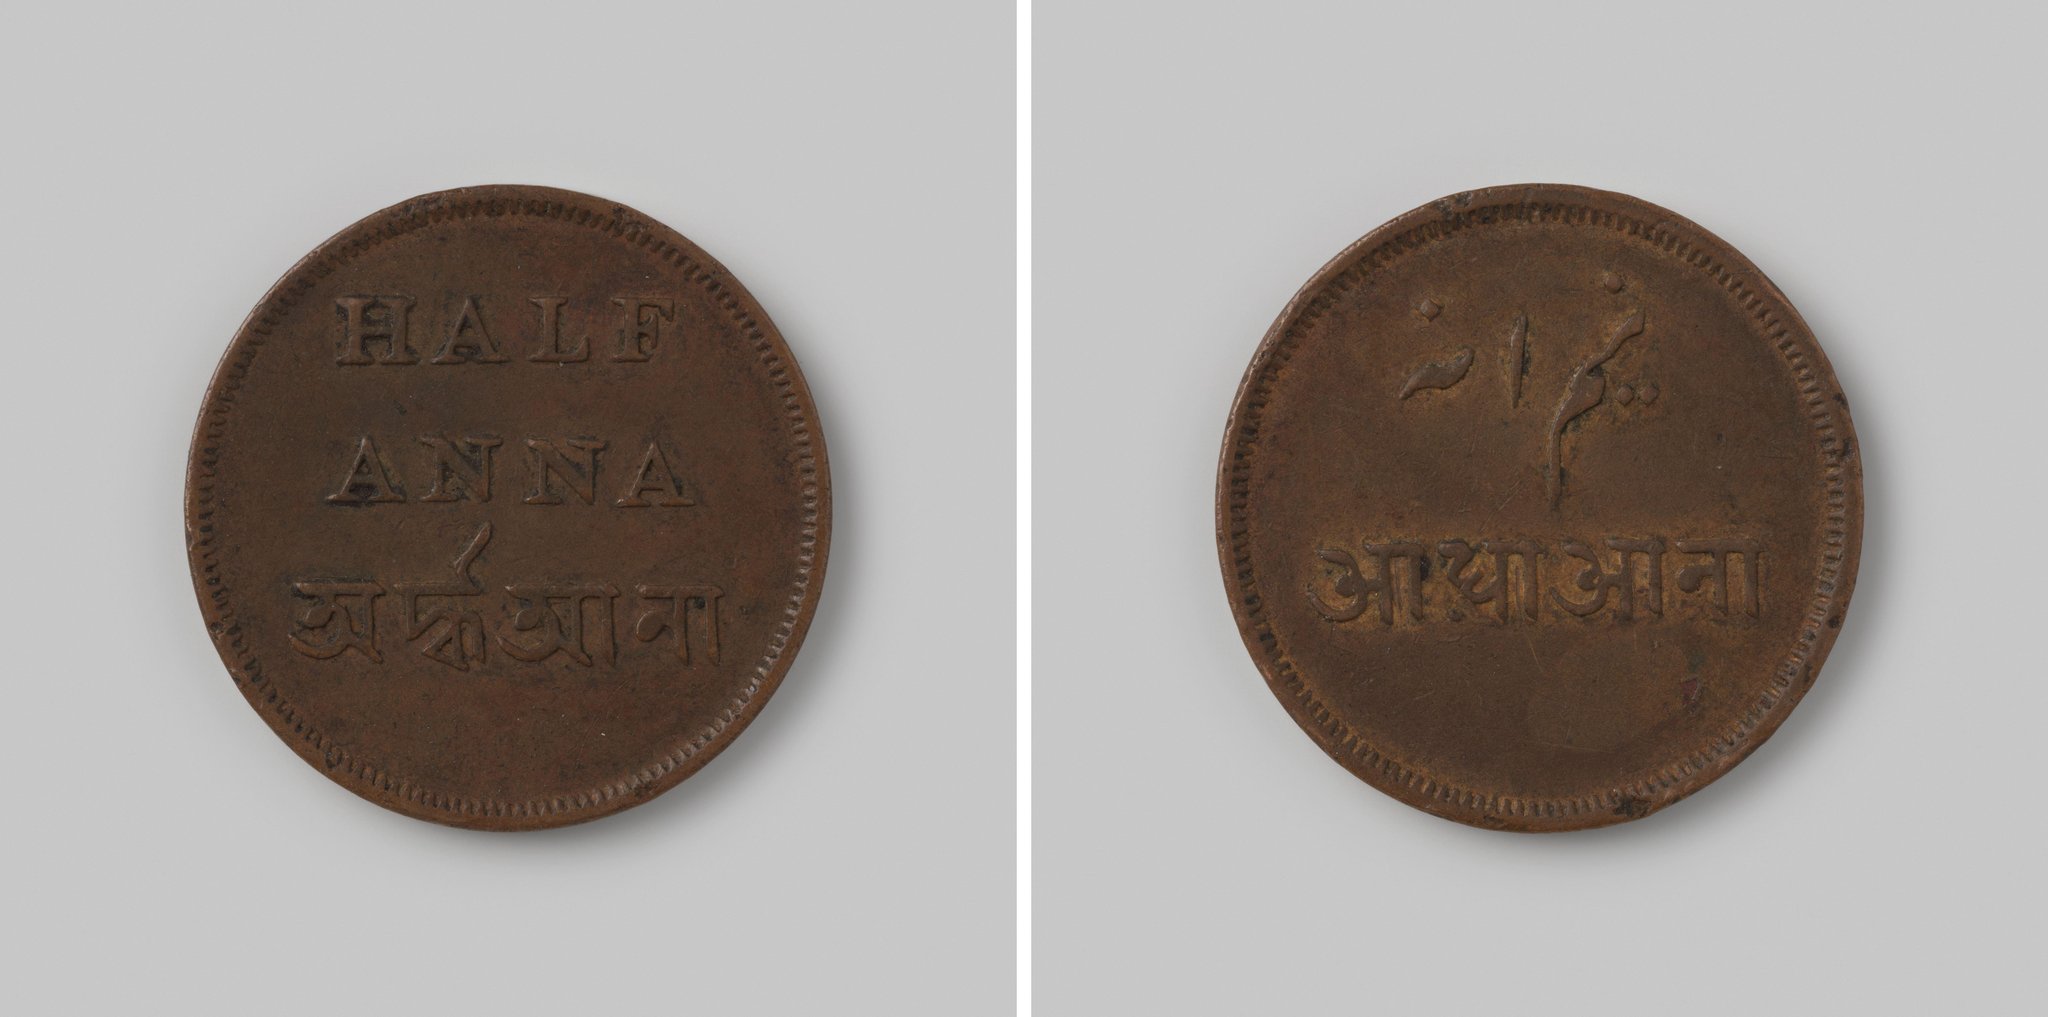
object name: coin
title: ½ anna uit Bengalen in India van de Engelse Oostindische Compagnie (EIC)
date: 1831-1835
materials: copper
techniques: striking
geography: kolkata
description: Koperen munt. Voorzijde: in bovenste twee regels waarde-aanduiding, half anna en in onderste twee regels waarde-aanduiding in Bengaals schrift. Keerzijde: in bovenste regel waarde-aanduiding in het Perzisch in Arabische schrift en in onderste regel waarde-aanduiding in Nagari-schrift. Na eerste letterteken klein opkomend maantje [=muntplaats Calcutta]. Gladde rand.